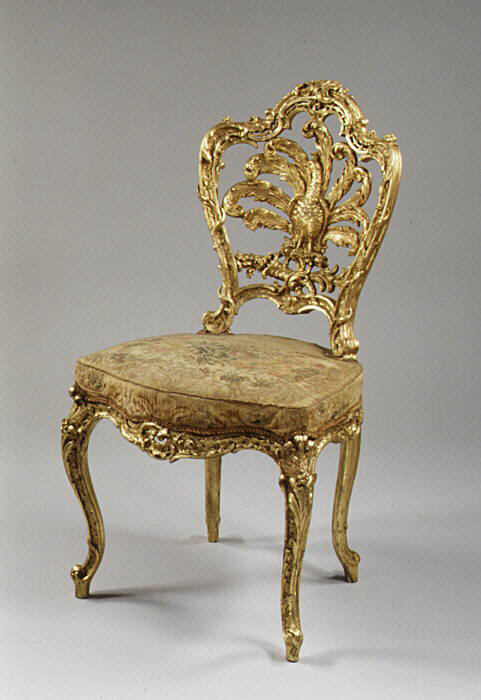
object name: side chair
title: Side chair (one of a pair)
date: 1834-1866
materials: gilt, wood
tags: peacocks